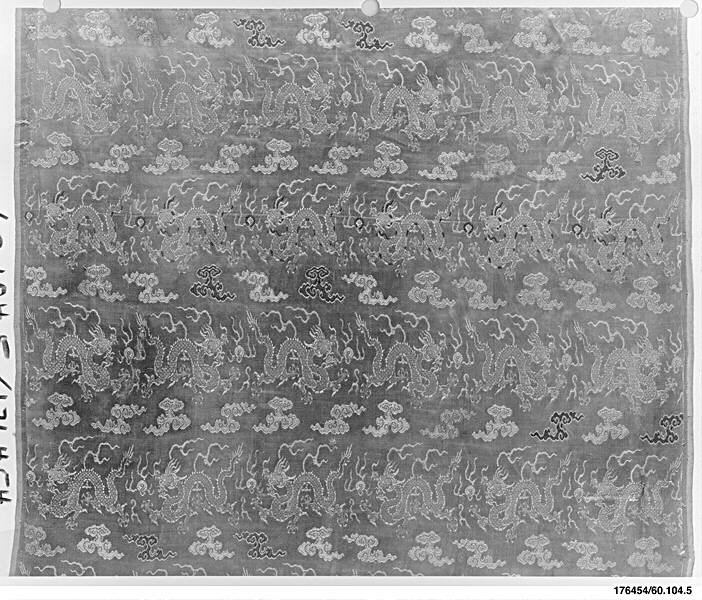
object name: panel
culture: chinese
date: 1701-1733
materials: metal thread, silk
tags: dragons